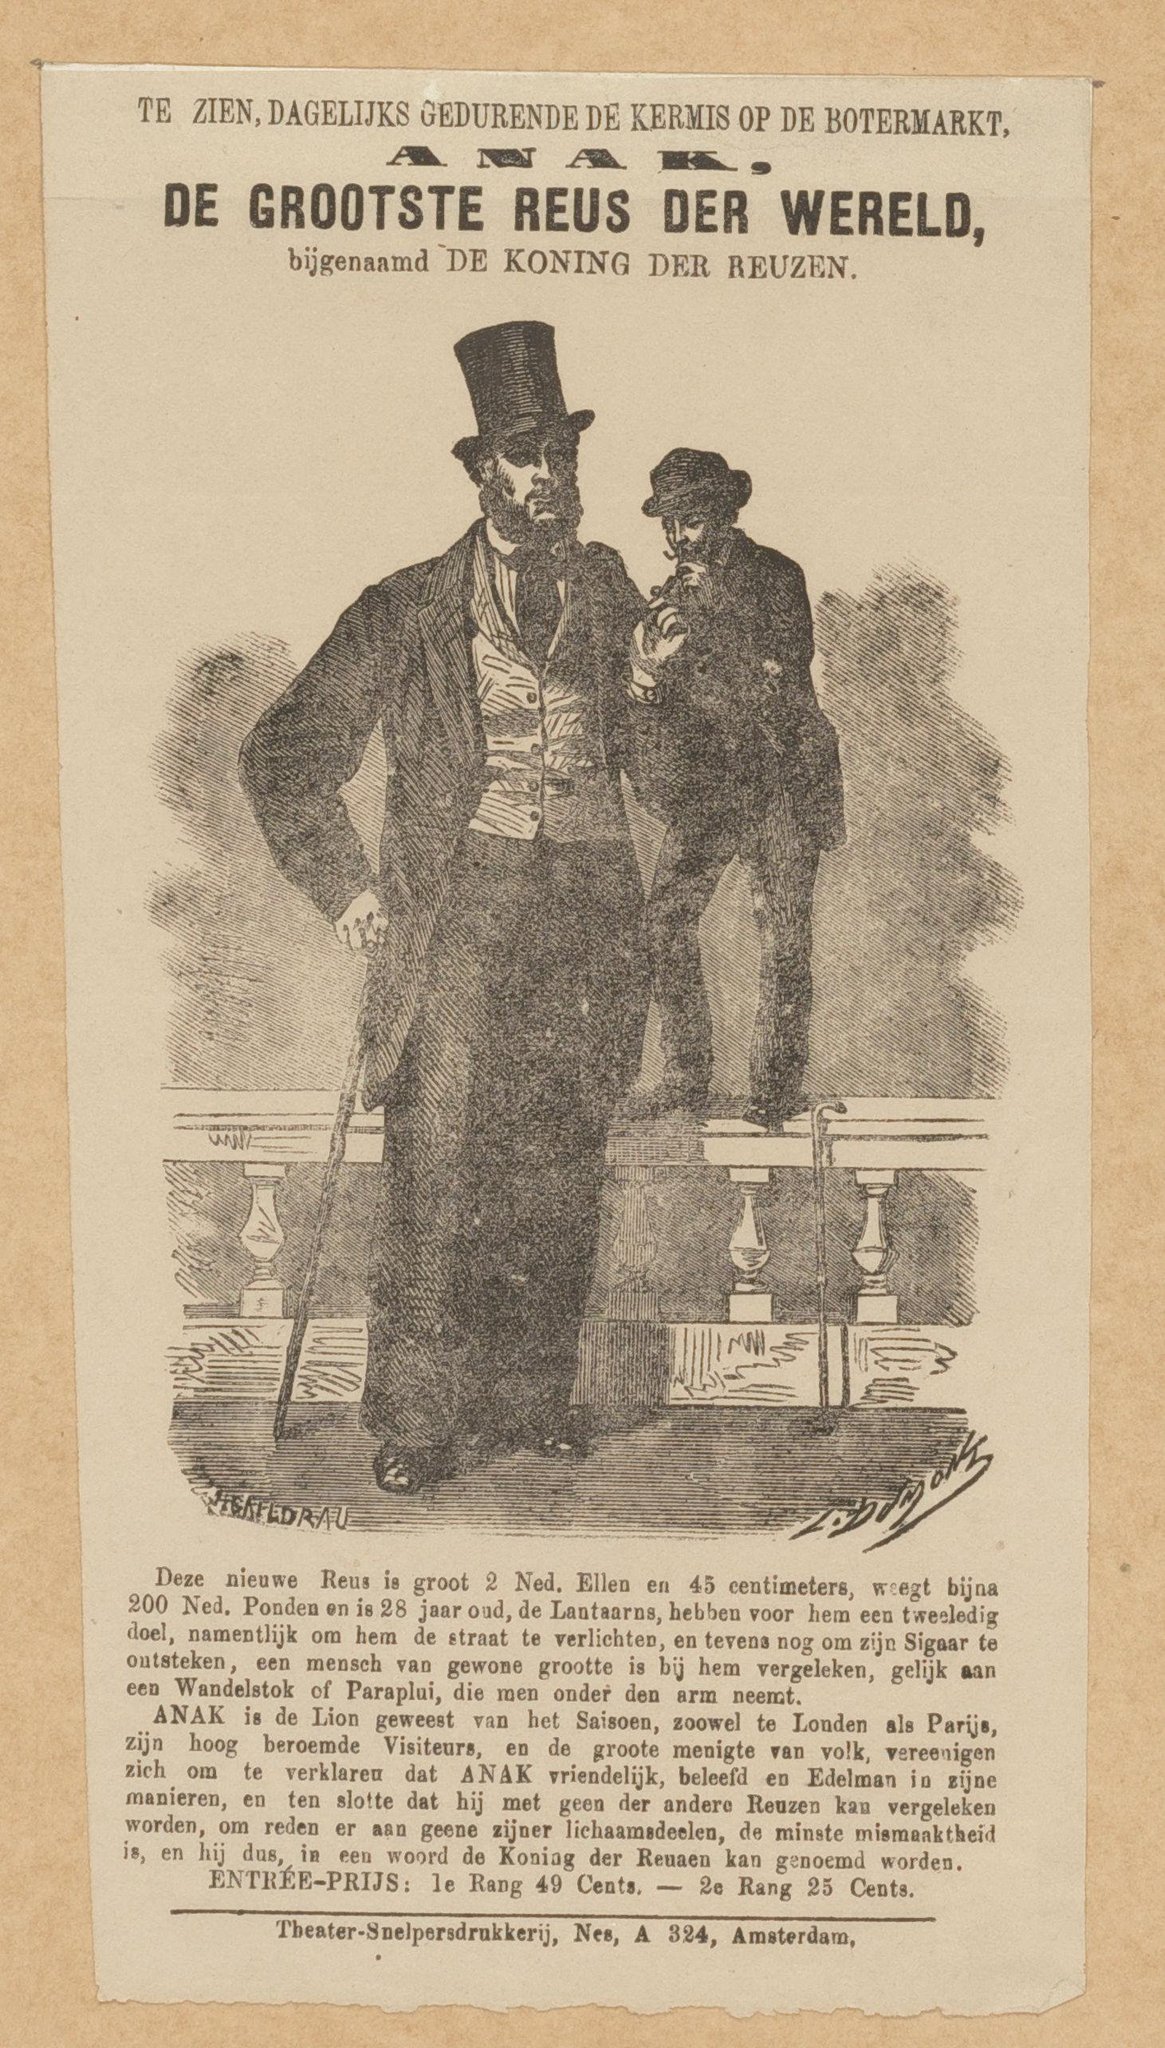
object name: print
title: Aankondiging voor Anak, een lang persoon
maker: jules gaildrau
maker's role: painter, print maker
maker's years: 1816-1898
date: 1826-1898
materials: paper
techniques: letterpress printing, line block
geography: amsterdam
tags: giants, colossi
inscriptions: stamp, stamp, collector's mark: Lugt 1641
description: Ter zien op de kermis op de botermarkt. Onderwerpsrubrieken binnen de Atlas Zeden en Gewoonten: Zeden en Gewoonten in Engeren Zin. Volksleven. Volksfeesten. Kermistypen, wondermenschen en dergelijken.